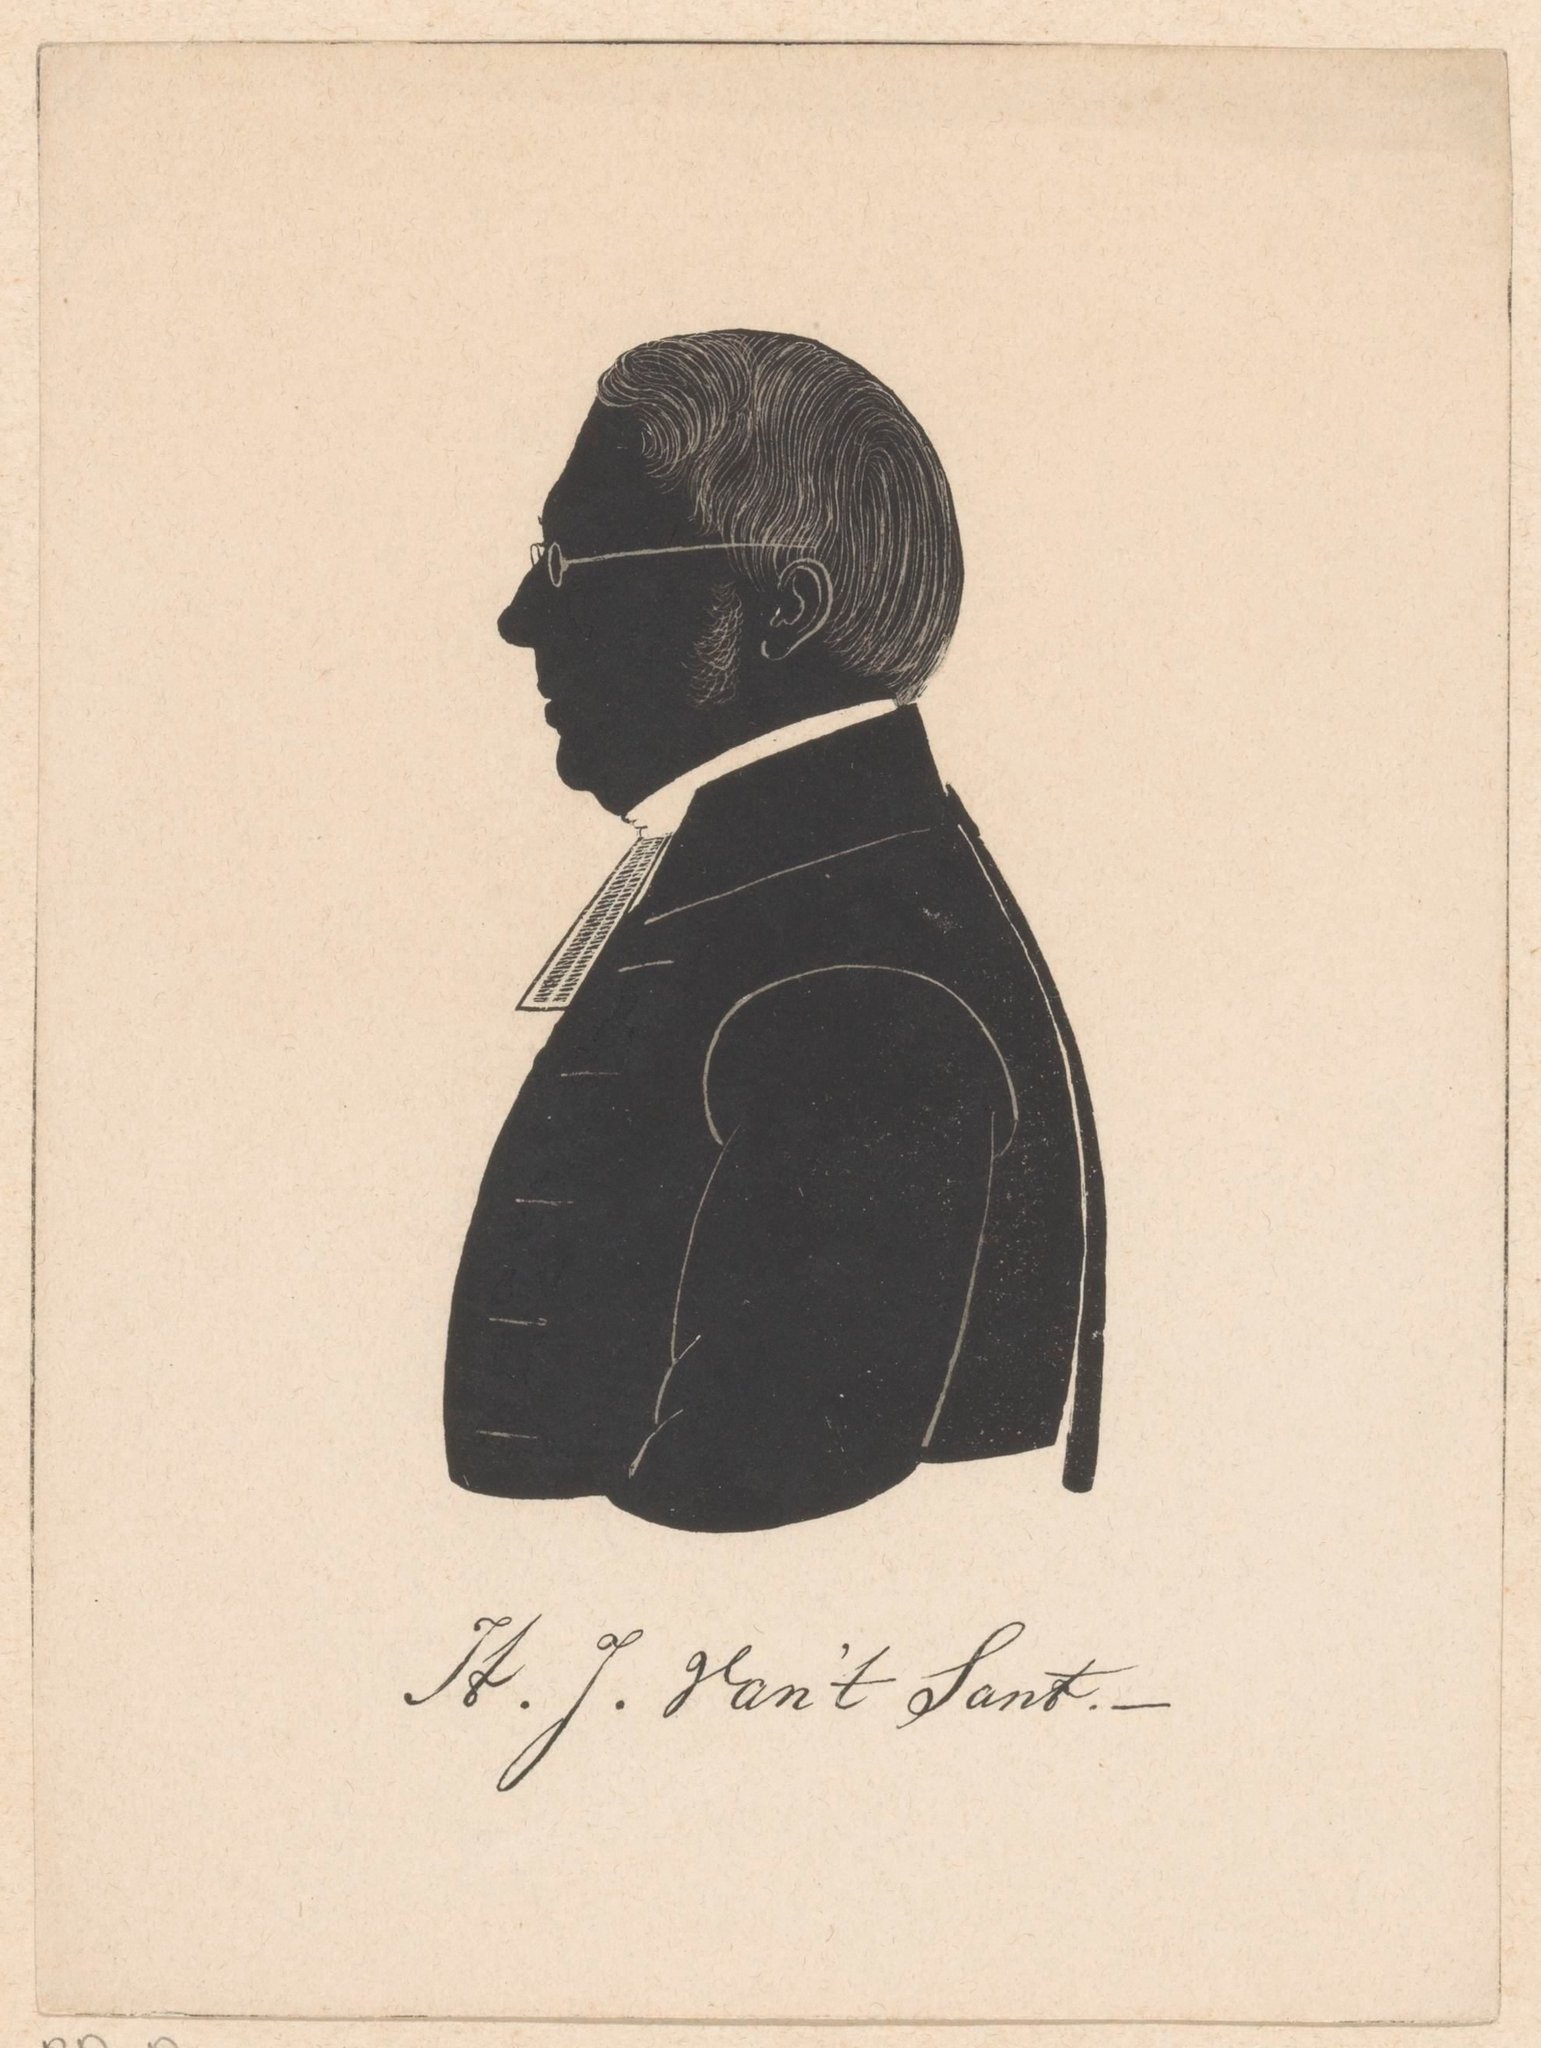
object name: print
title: Silhouetportret van H.J. van 't Sant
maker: pieter barbiers (iv)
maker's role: painter, print maker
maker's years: 1798-1848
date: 1809-1848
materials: paper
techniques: hand coloring, lithograph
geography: netherlands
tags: historical persons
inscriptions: collector's mark: Lugt 2228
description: Onder het portret de signatuur van de geportretteerde.